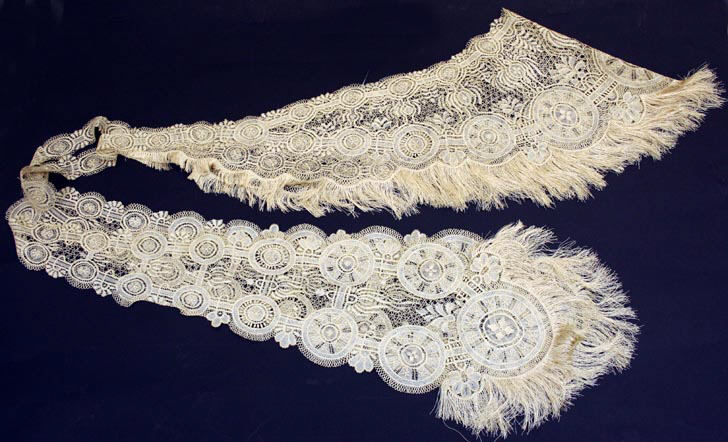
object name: fichu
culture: american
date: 1834-1866